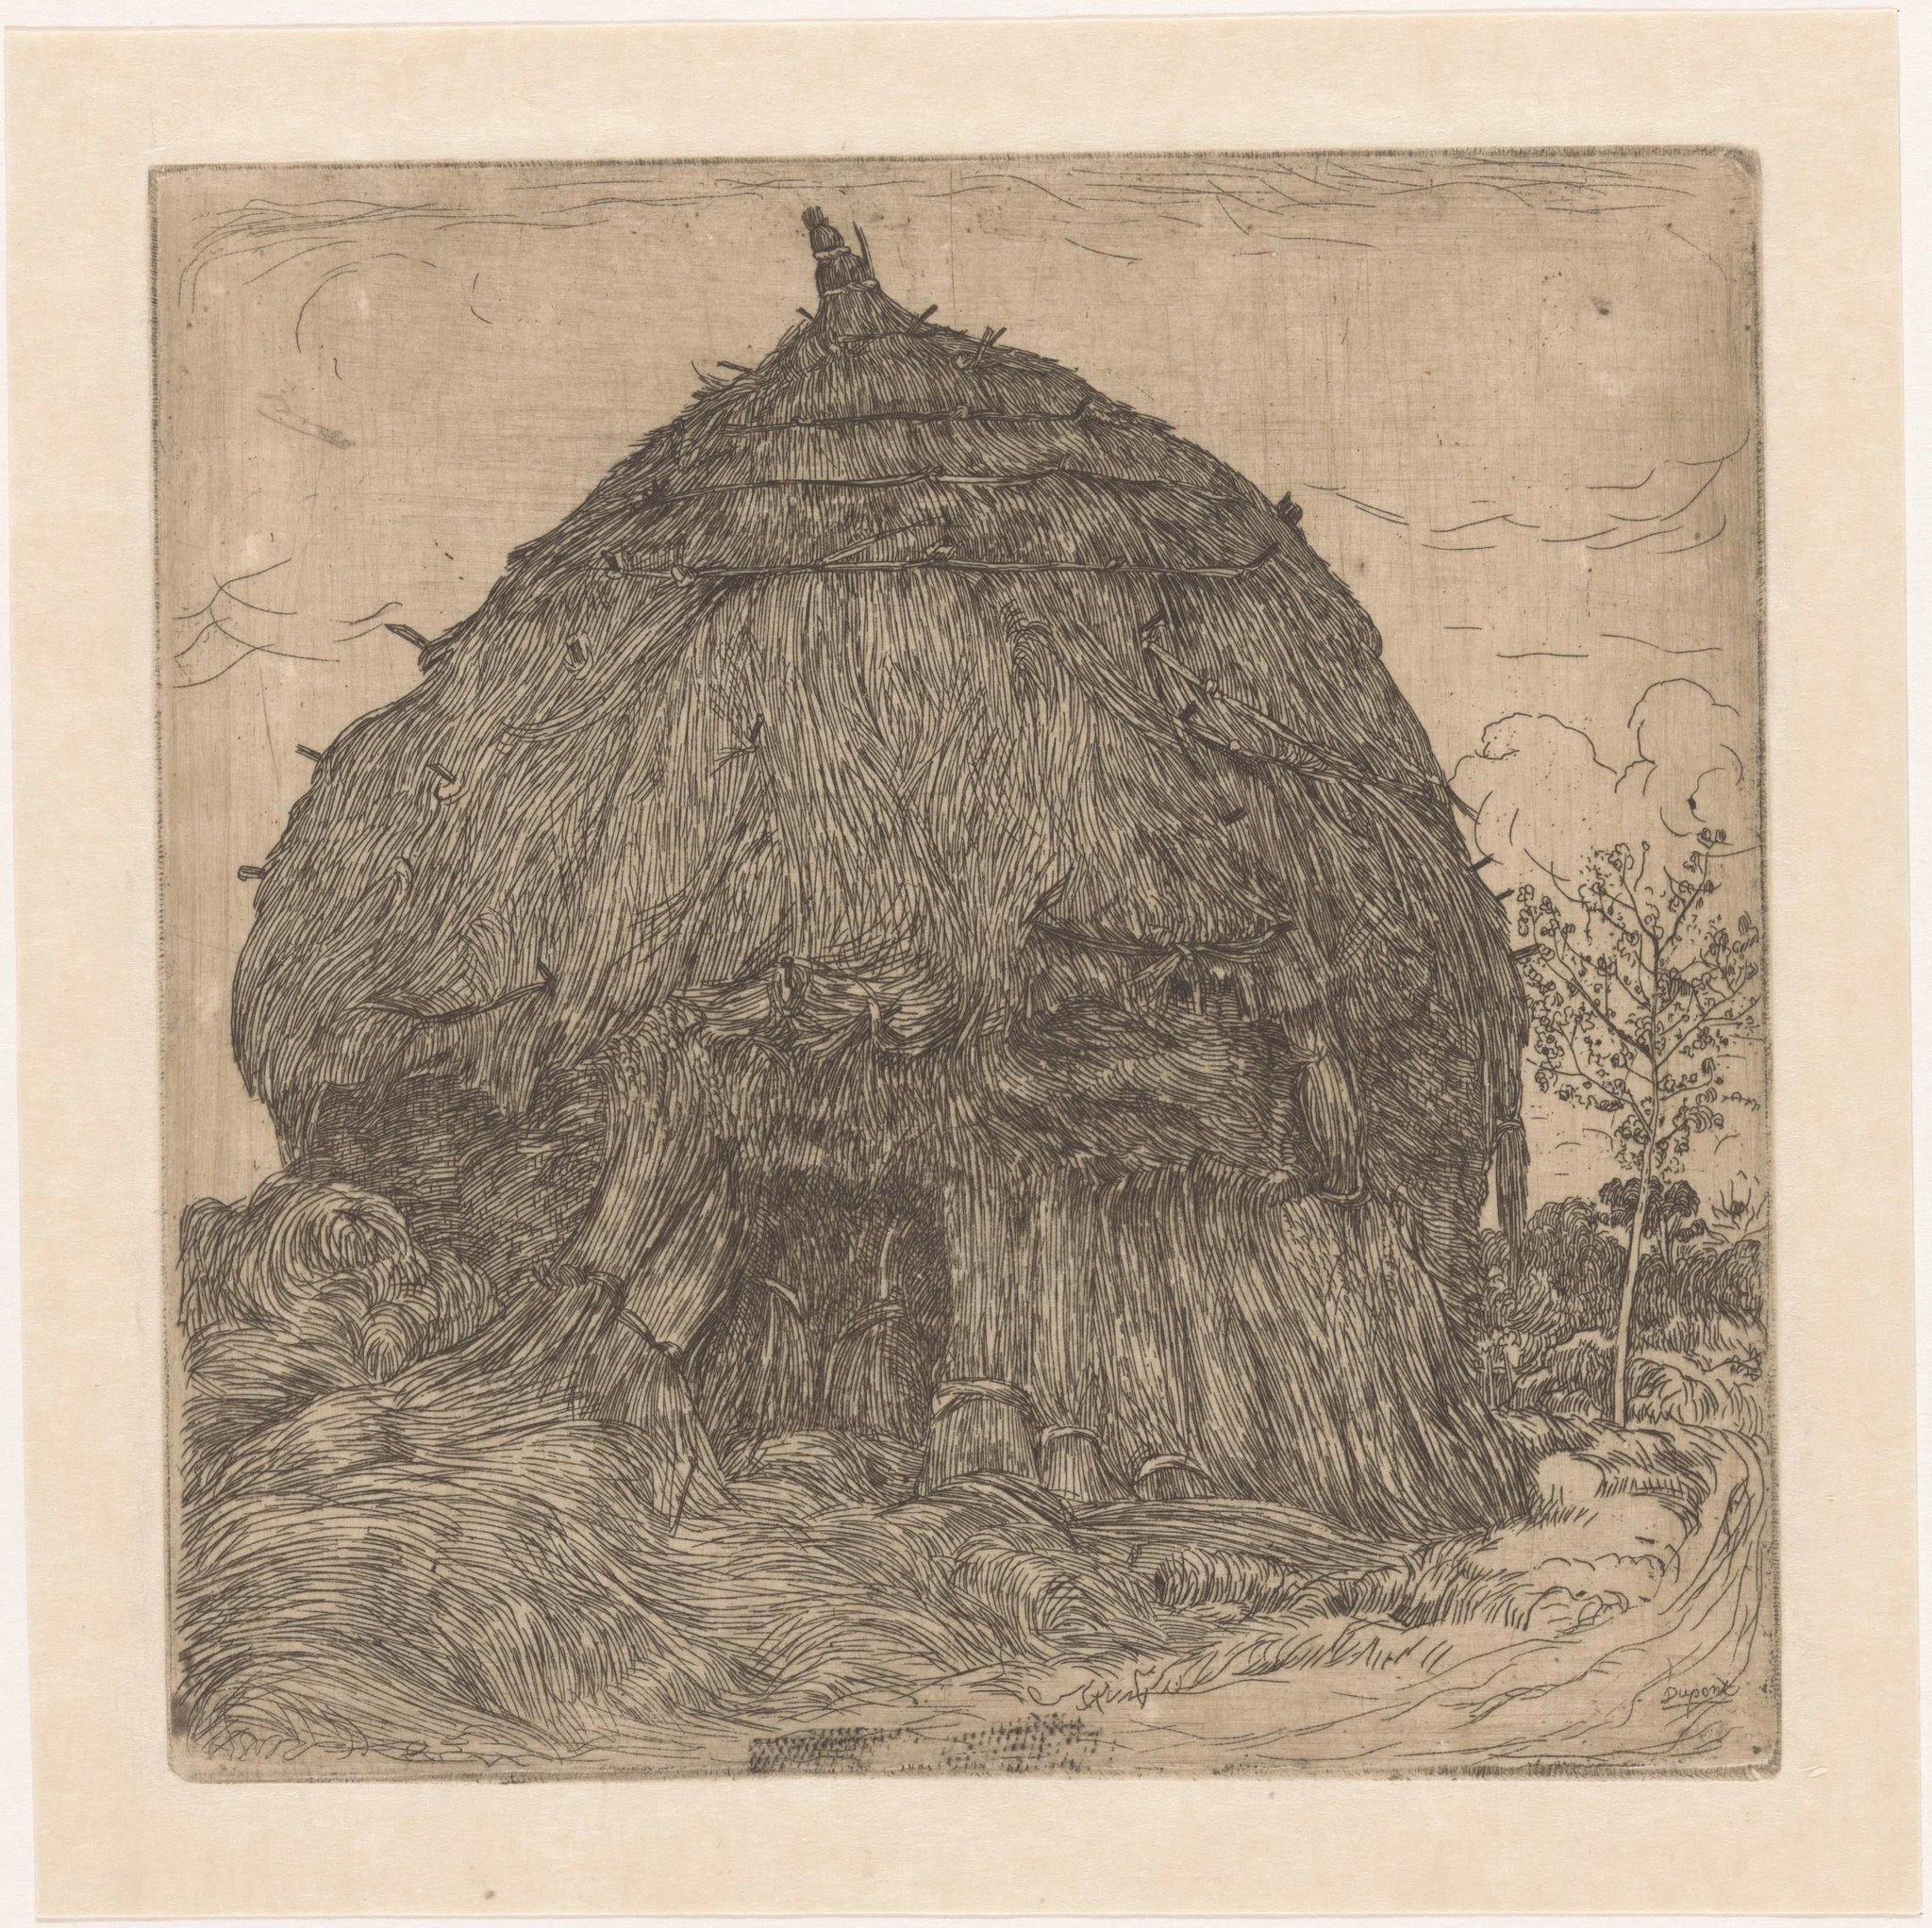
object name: print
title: Hooiopper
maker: pieter dupont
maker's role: draughtsman, print maker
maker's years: 1870-1911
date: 1894-1895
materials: paper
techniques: intaglio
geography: north holland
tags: hay-stack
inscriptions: collector's mark: Lugt 2233